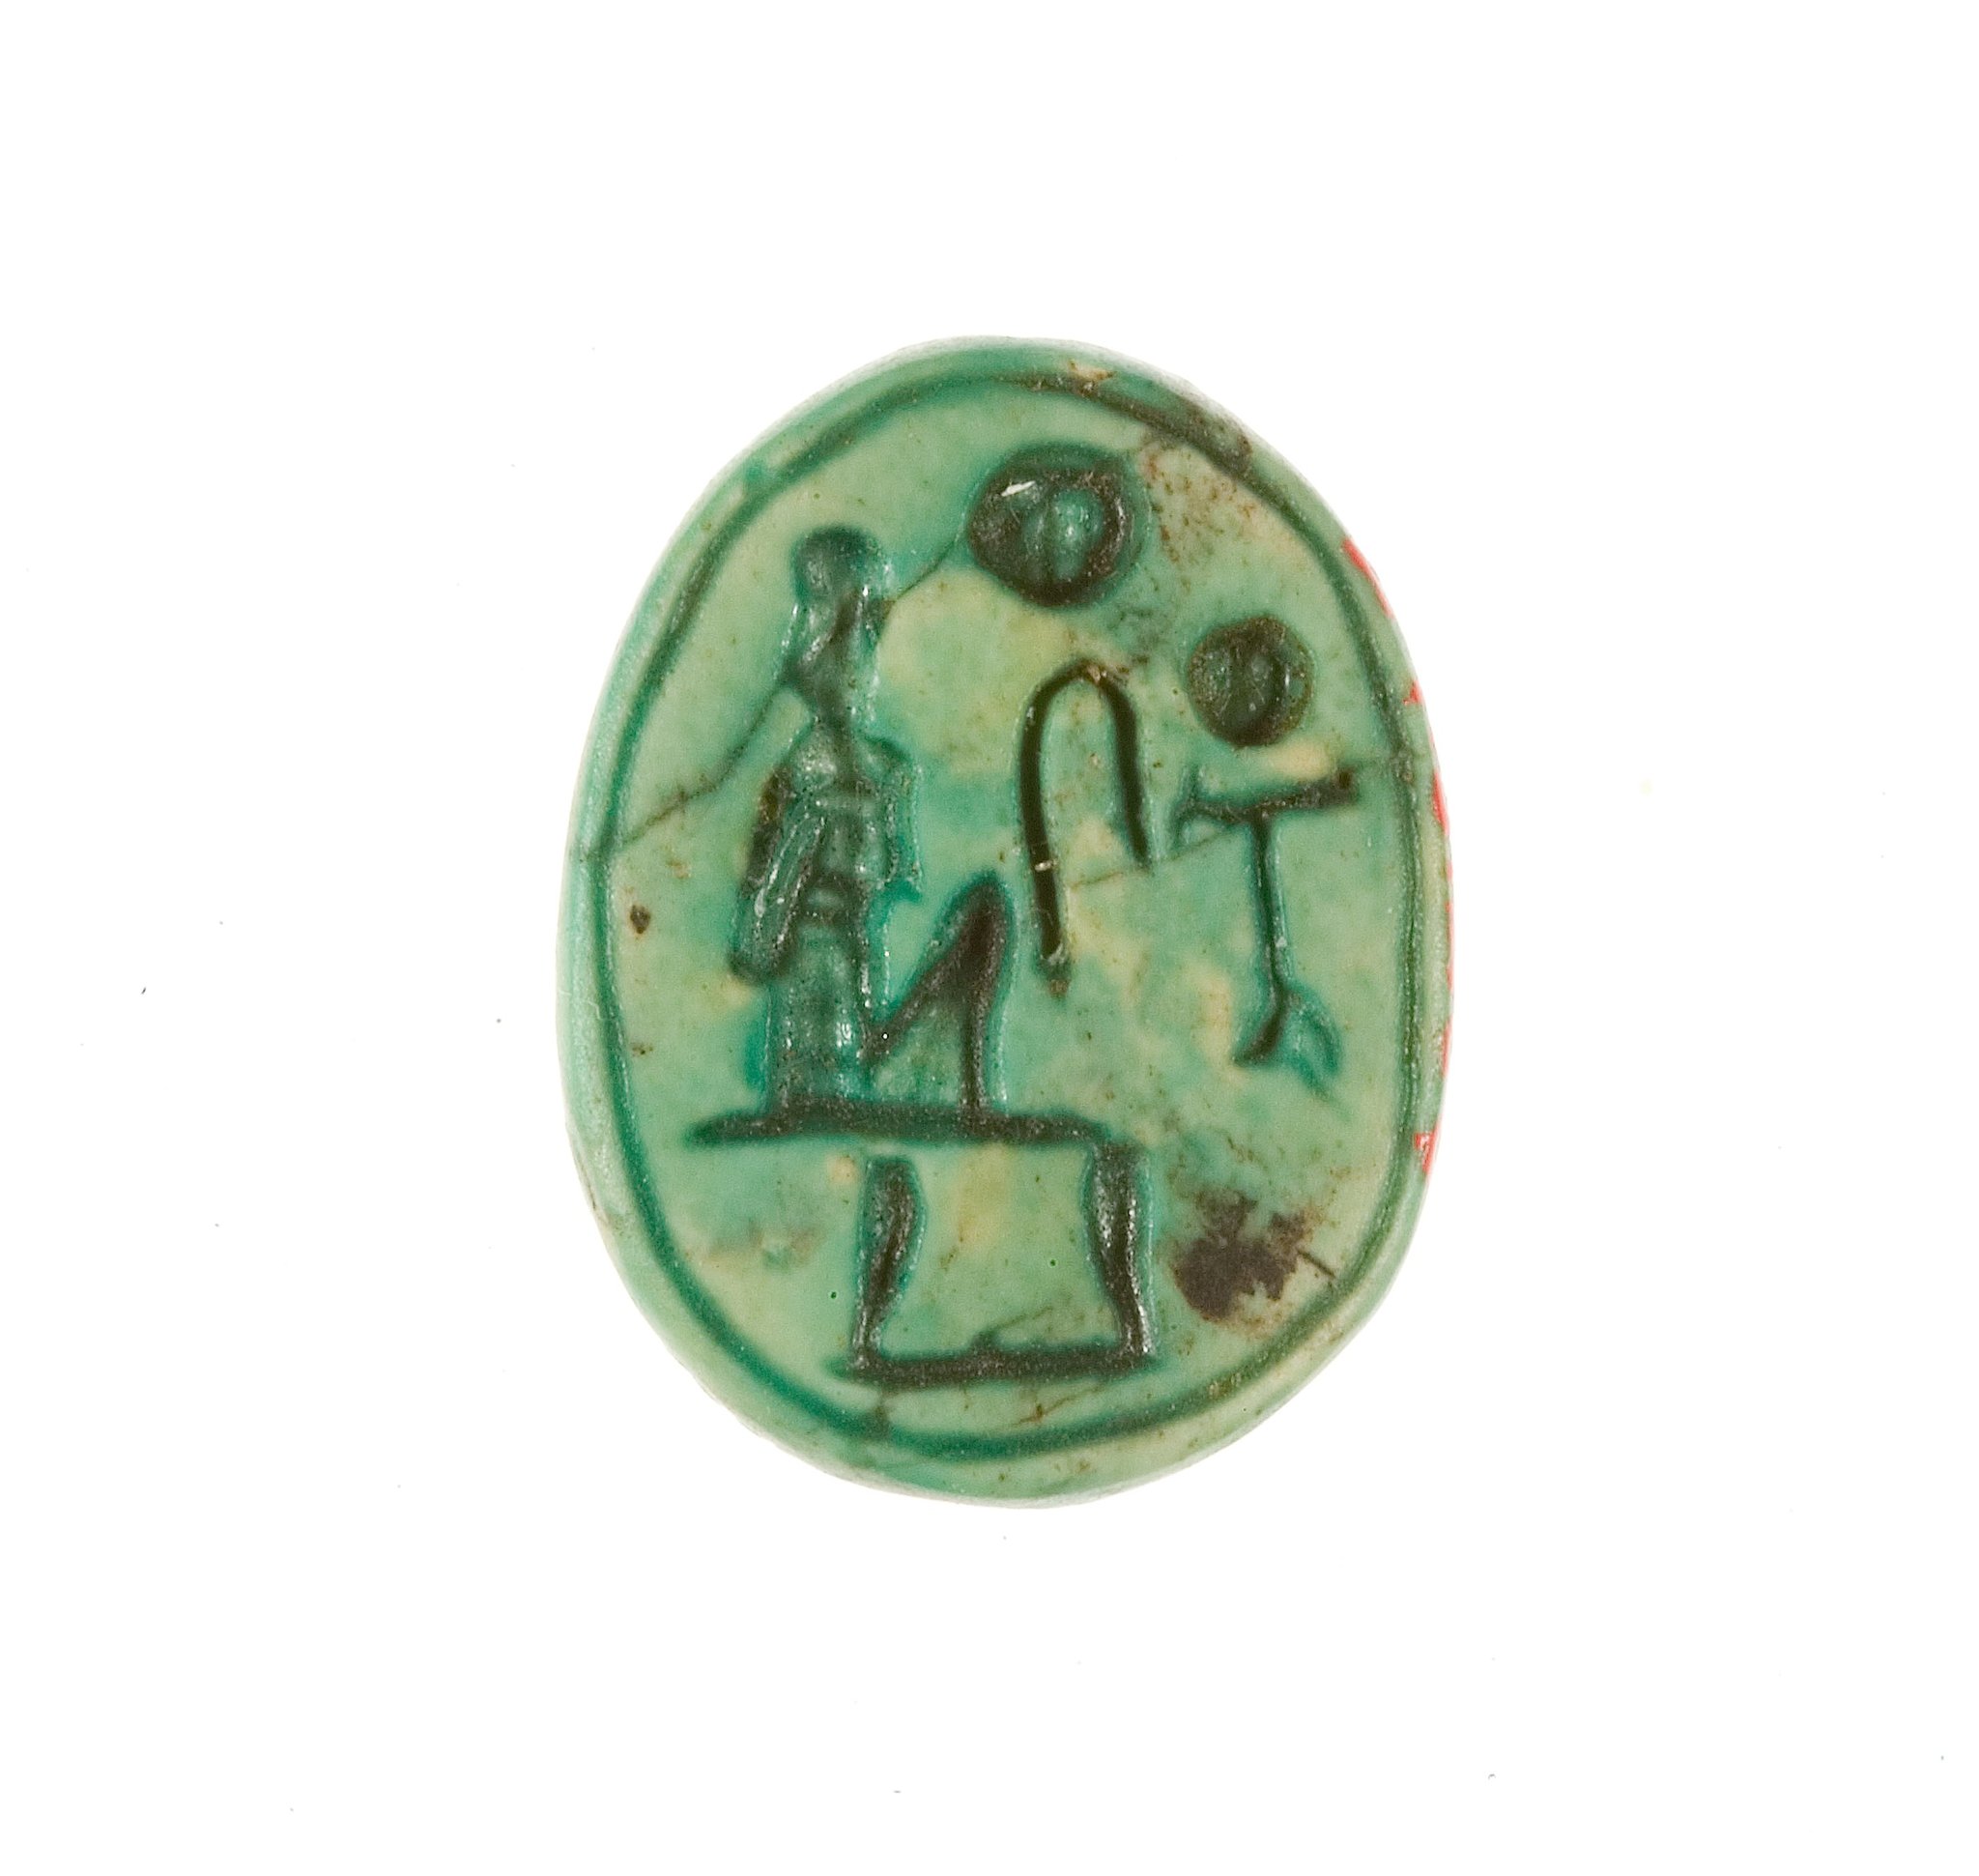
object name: scarab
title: Scarab Inscribed Maatkare (Hatshepsut), She Lives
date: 1479-1458 BCE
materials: stone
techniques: glazing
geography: egypt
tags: hieroglyphs,scarabs